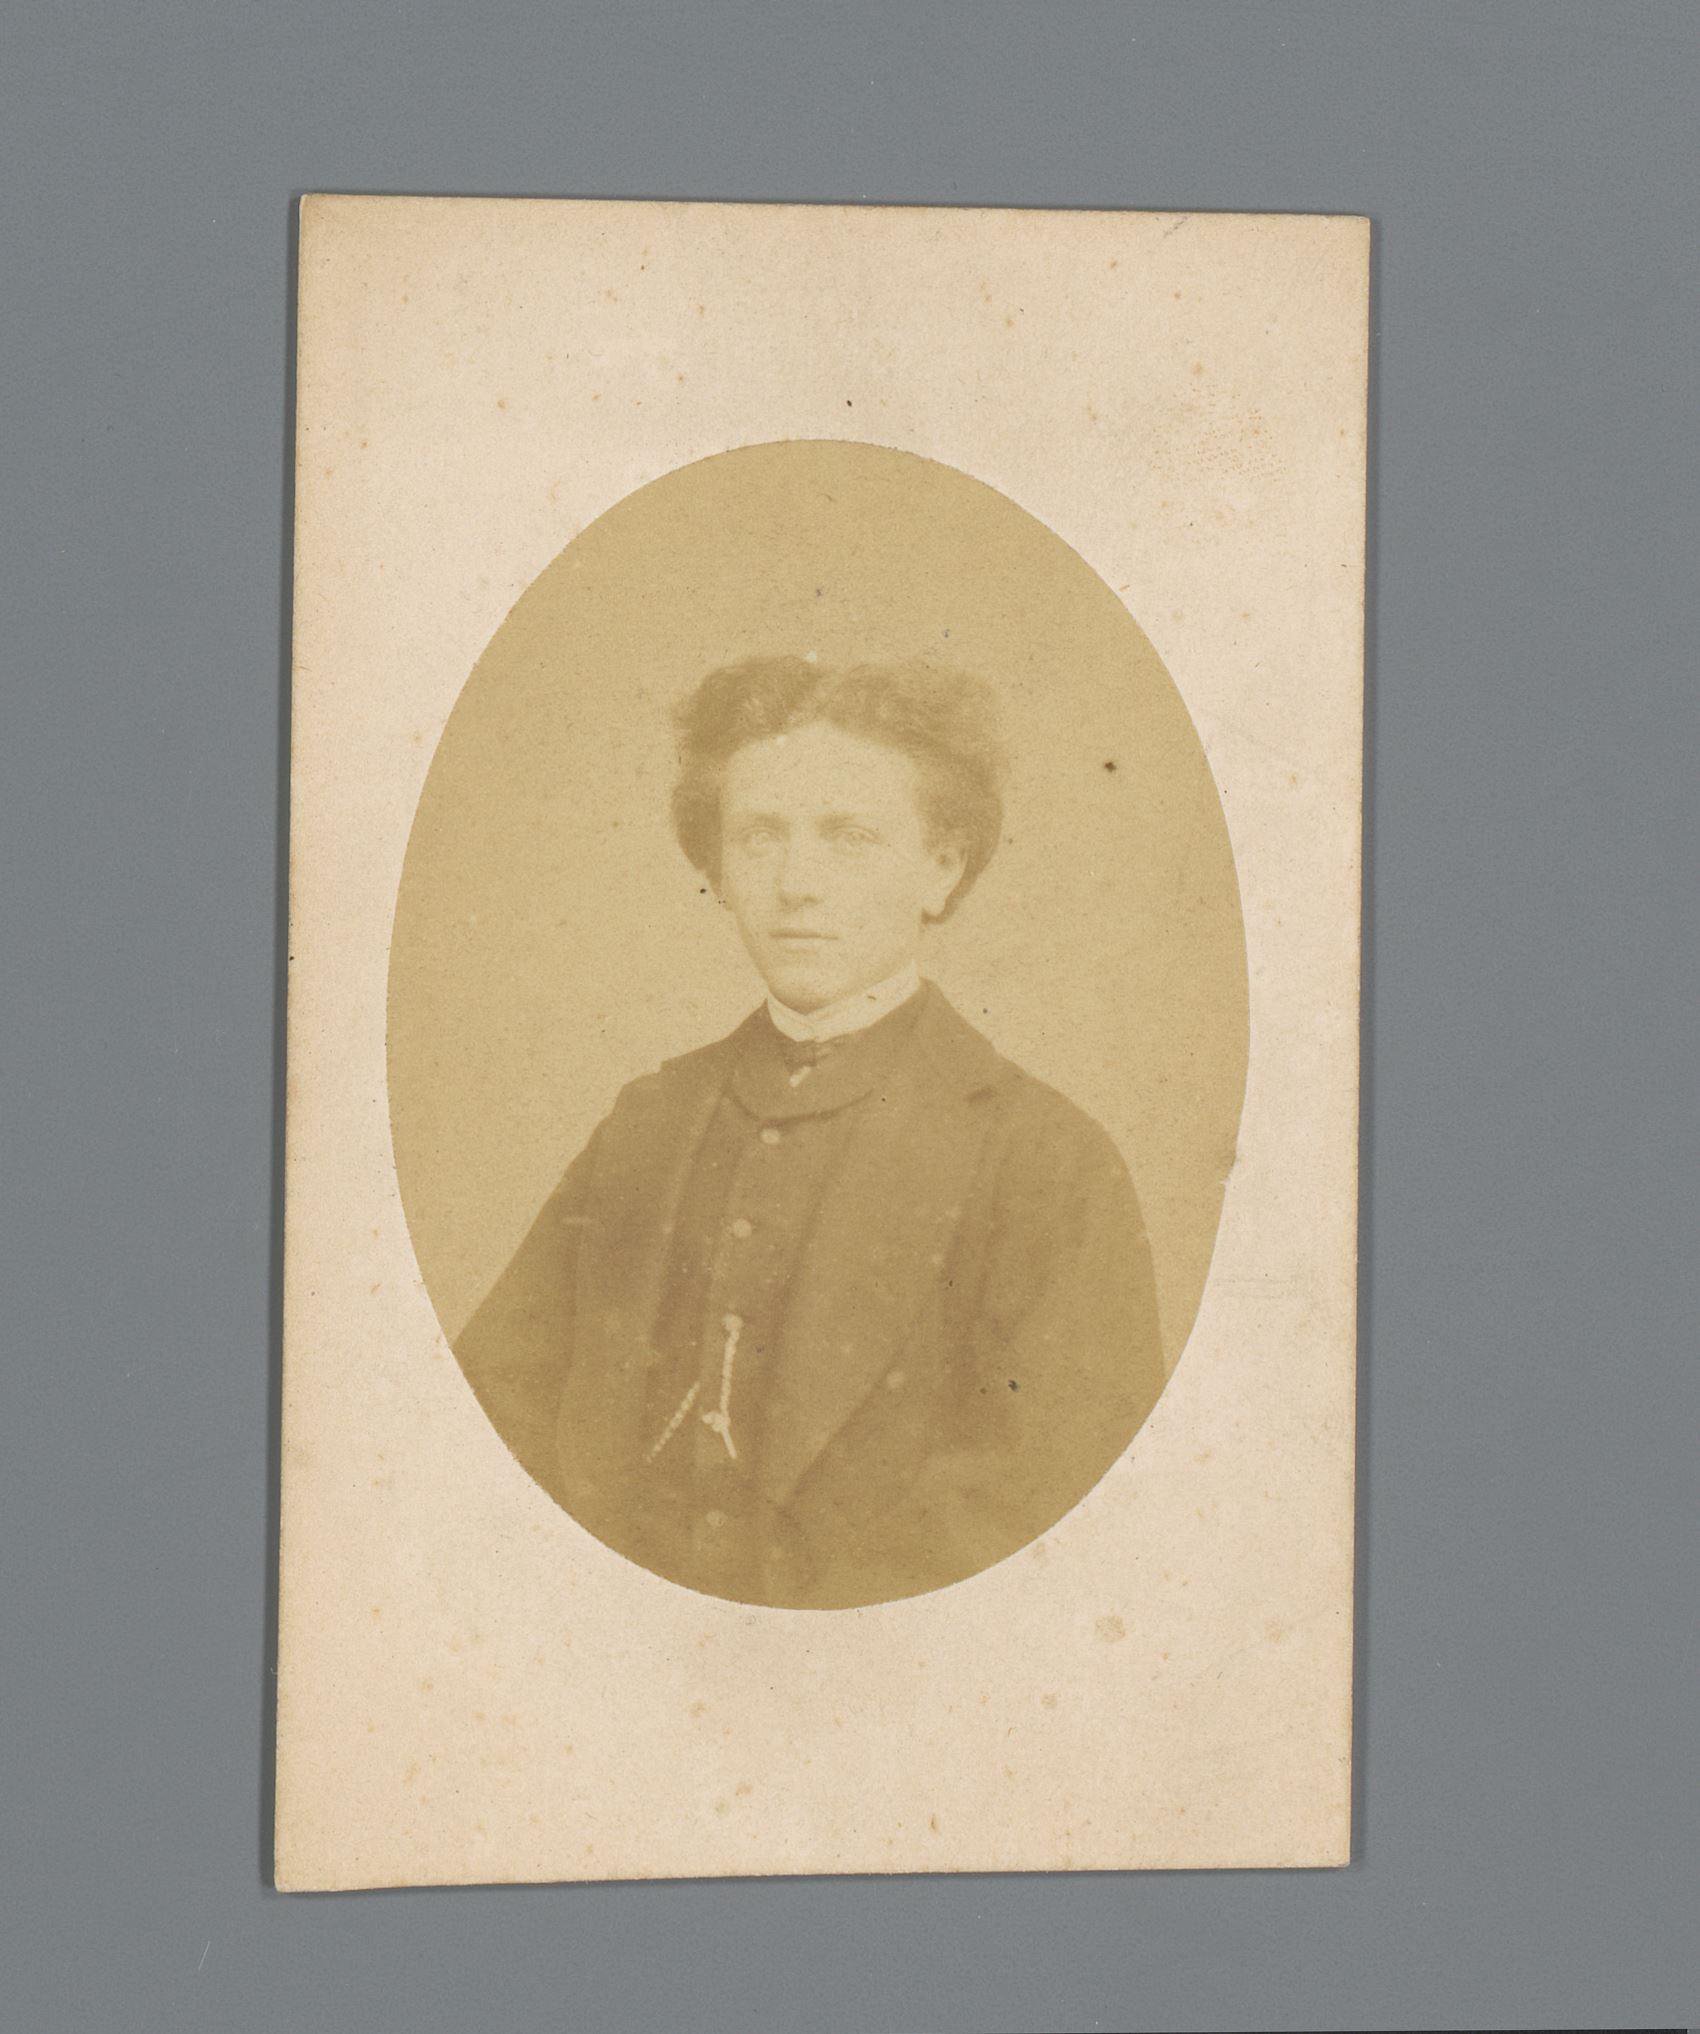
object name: carte de visite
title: Portret van Frans Swaenen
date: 1865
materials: cardboard, paper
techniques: albumen print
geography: antwerp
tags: historical persons, youth, adolescent, antwerp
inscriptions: inscription: ‘Etablissement Photographique/ de/ Stalins & Janssens/ 38, Rempart du Lombard, 38/ Anvers.’, inscription: ‘Frans Swaenen/ 1865.’